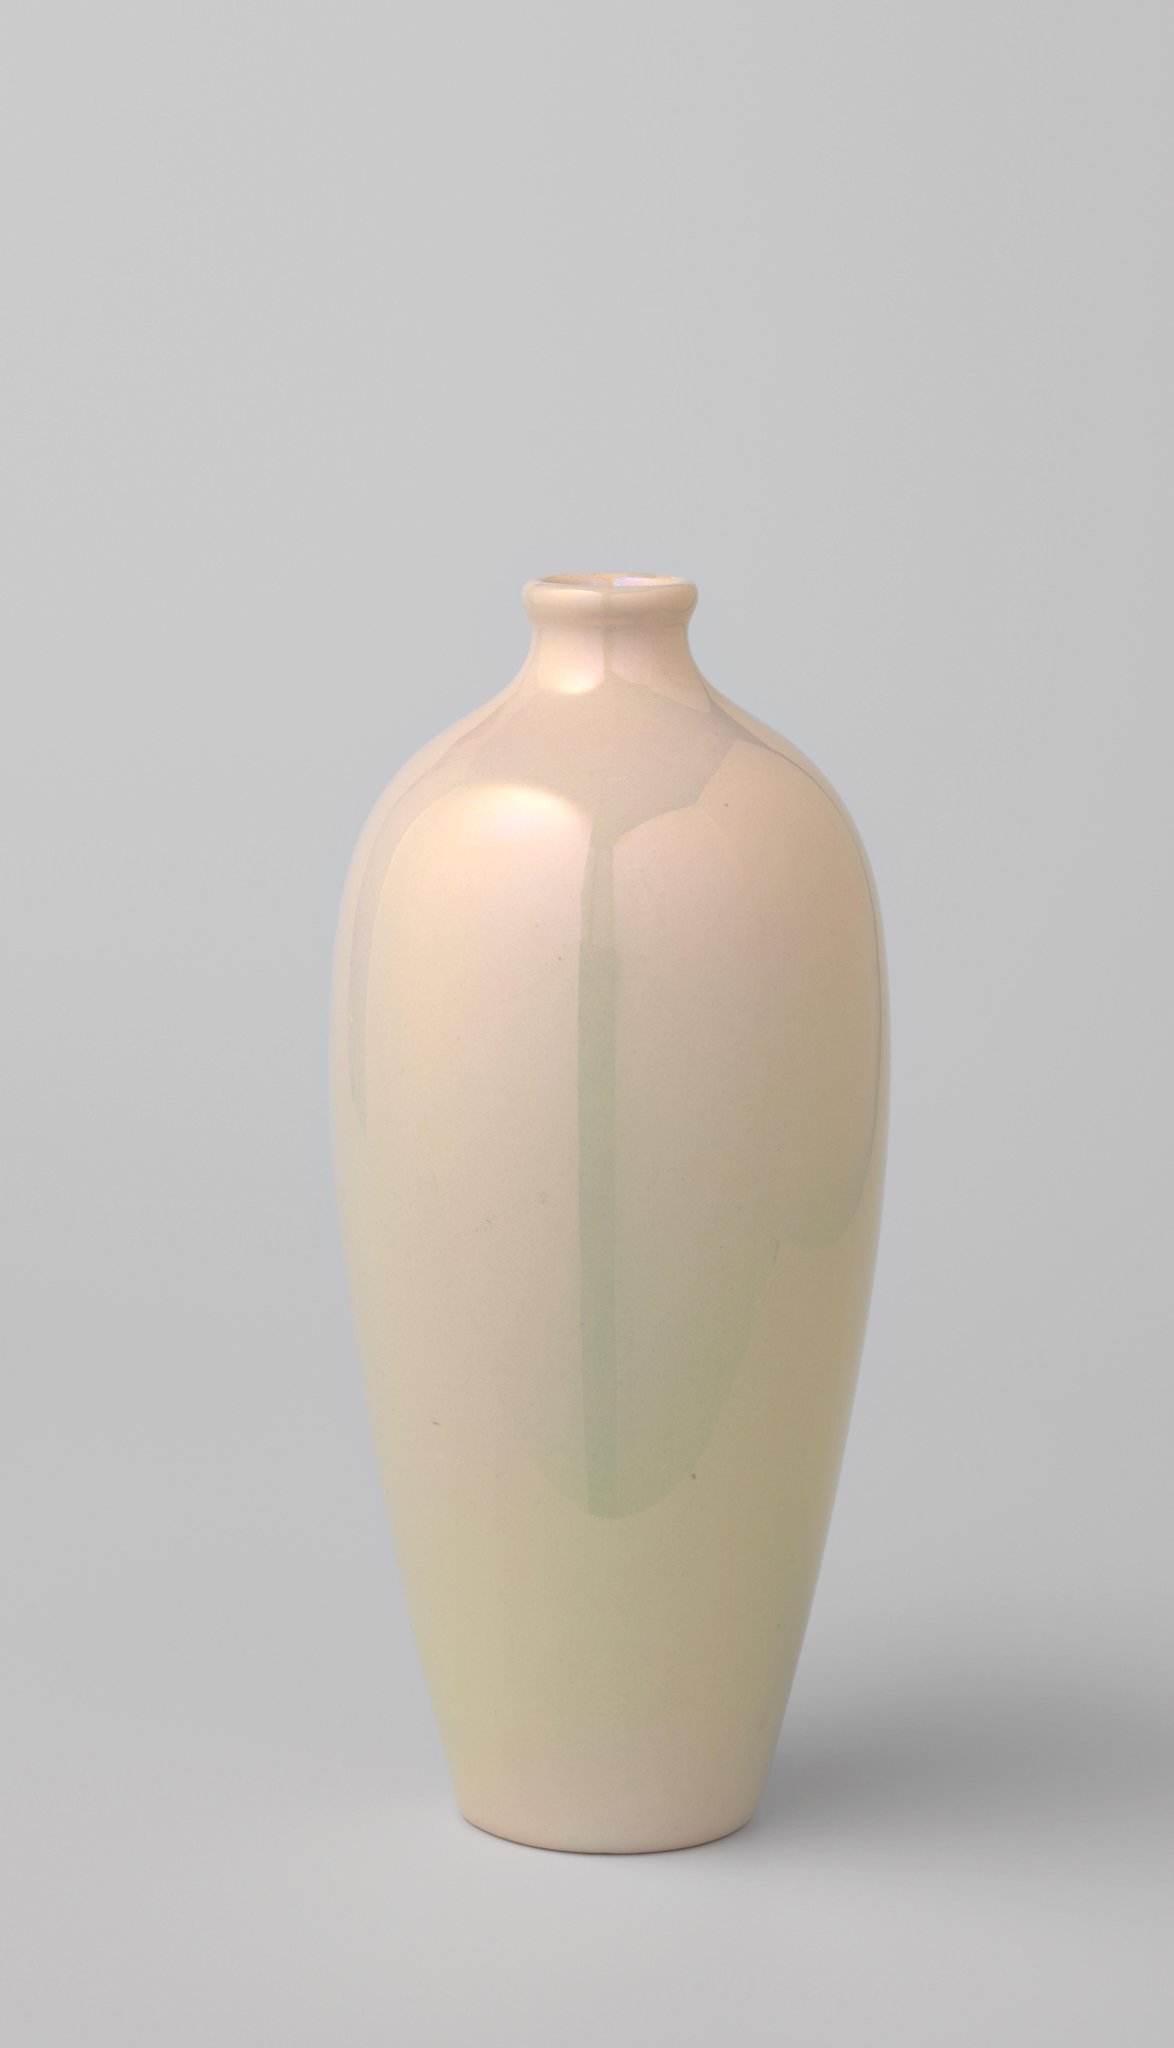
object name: vase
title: Vaas met groengele lusterglazuur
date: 1915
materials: earthenware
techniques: vitrification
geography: utrecht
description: Vase. Earthenware. Utrecht, c. 1910 - 1920, made by Kunstaardewerkfabriek St. Lukas, factory under te direction of G.J.D. Offermans. Gift of jonkvrouw C.I. en jonkvrouw H.M.A.F. Six, 1972.